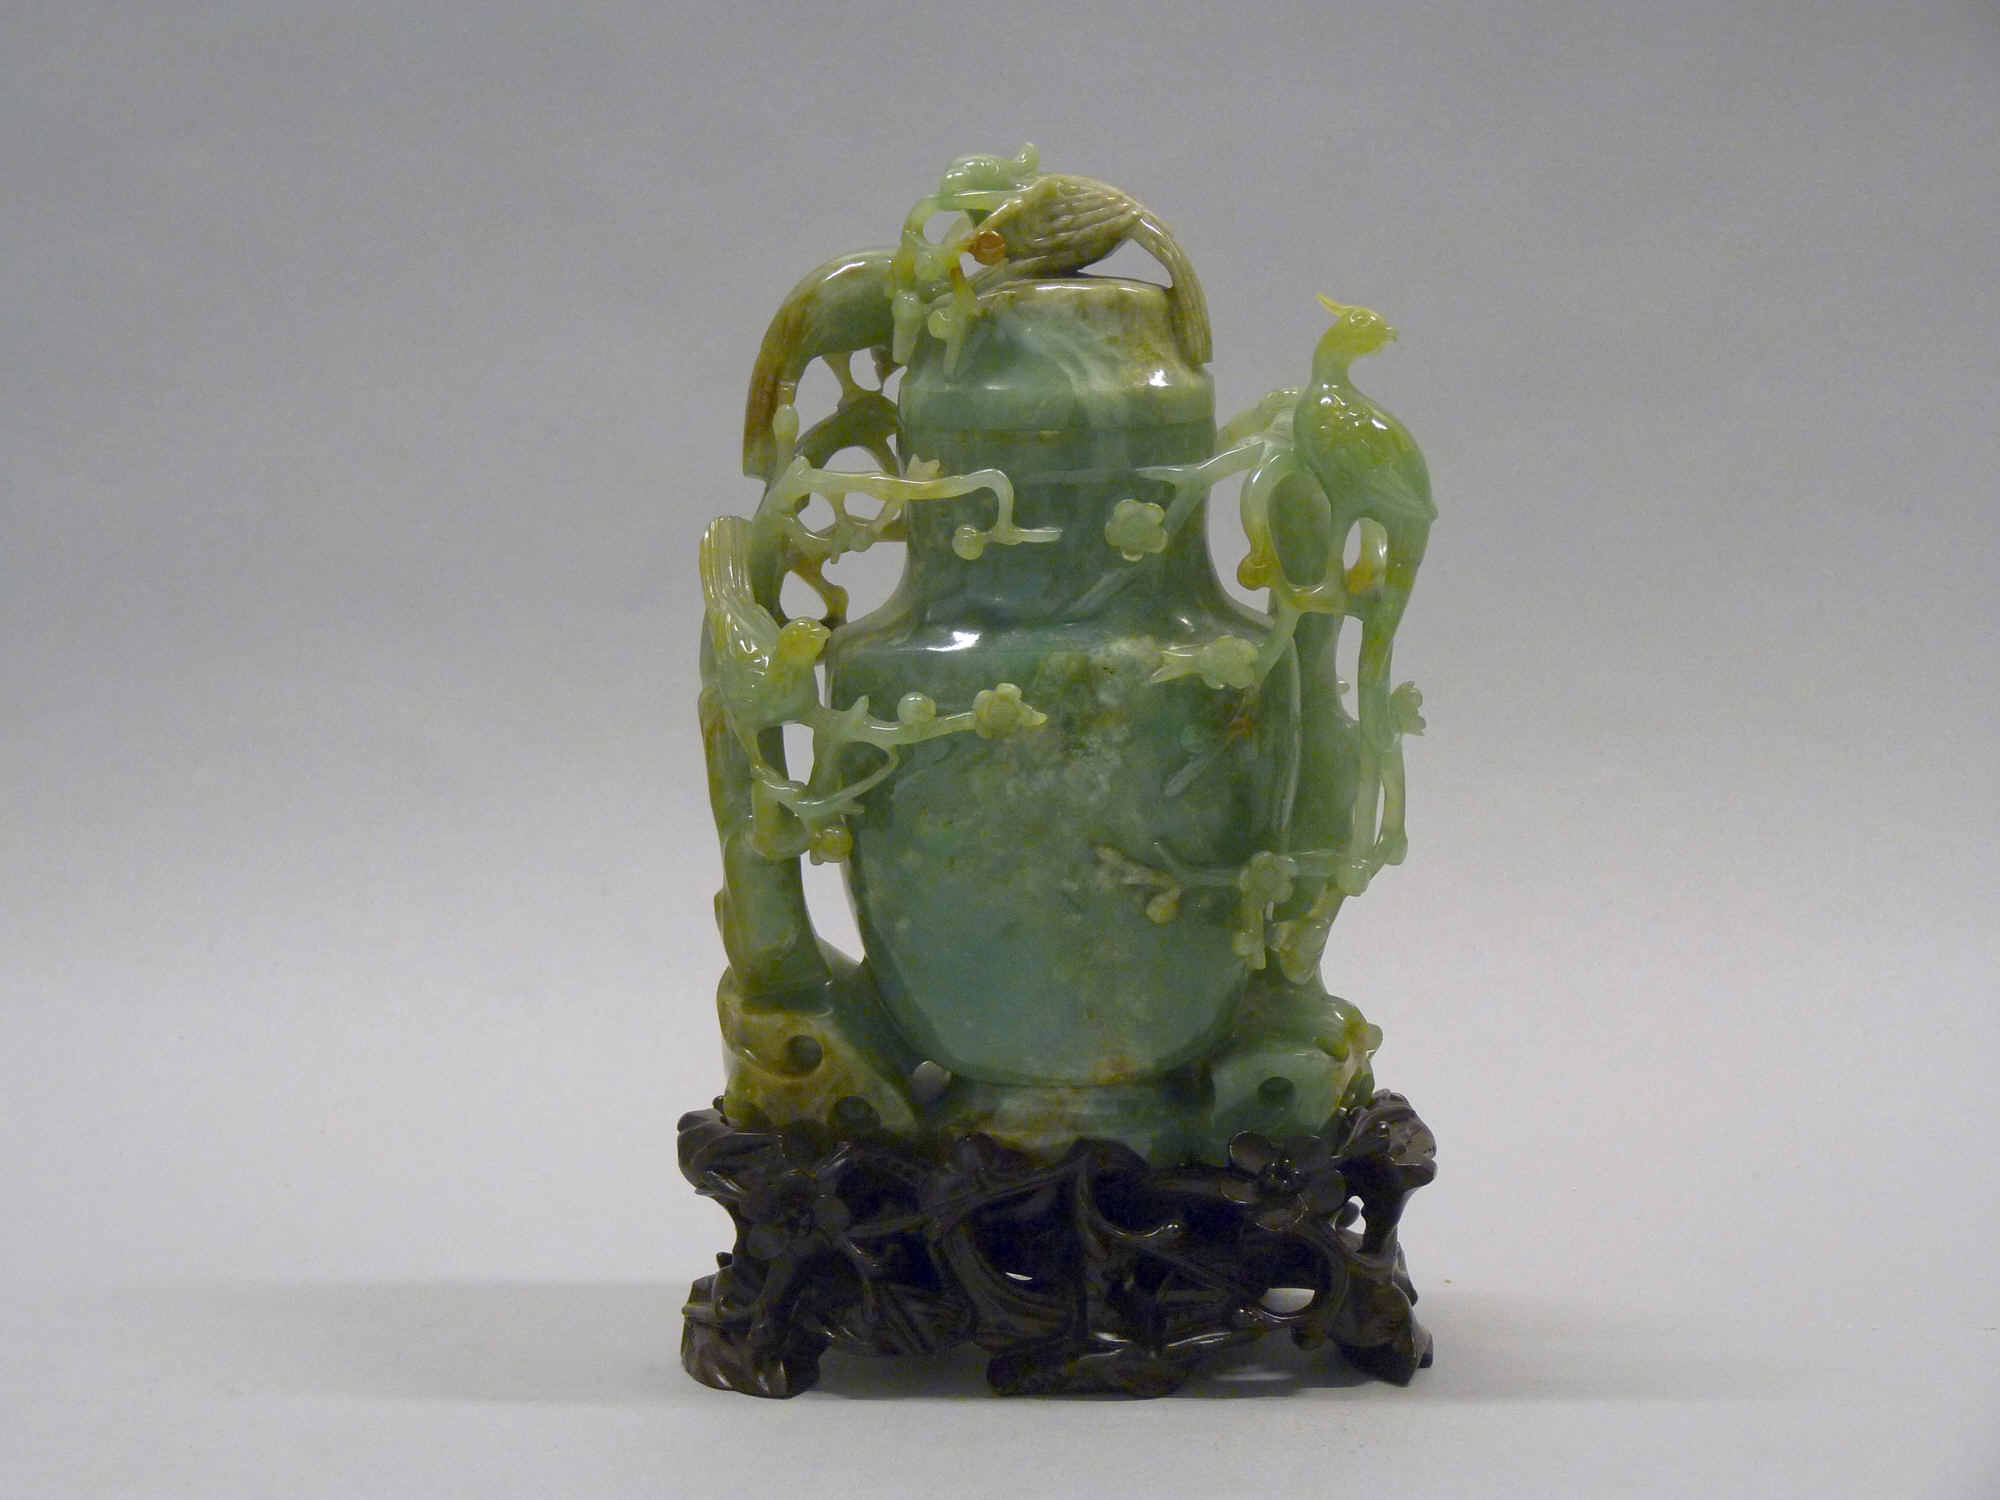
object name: covered vase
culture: chinese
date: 1701-1800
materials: jade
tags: birds,plants